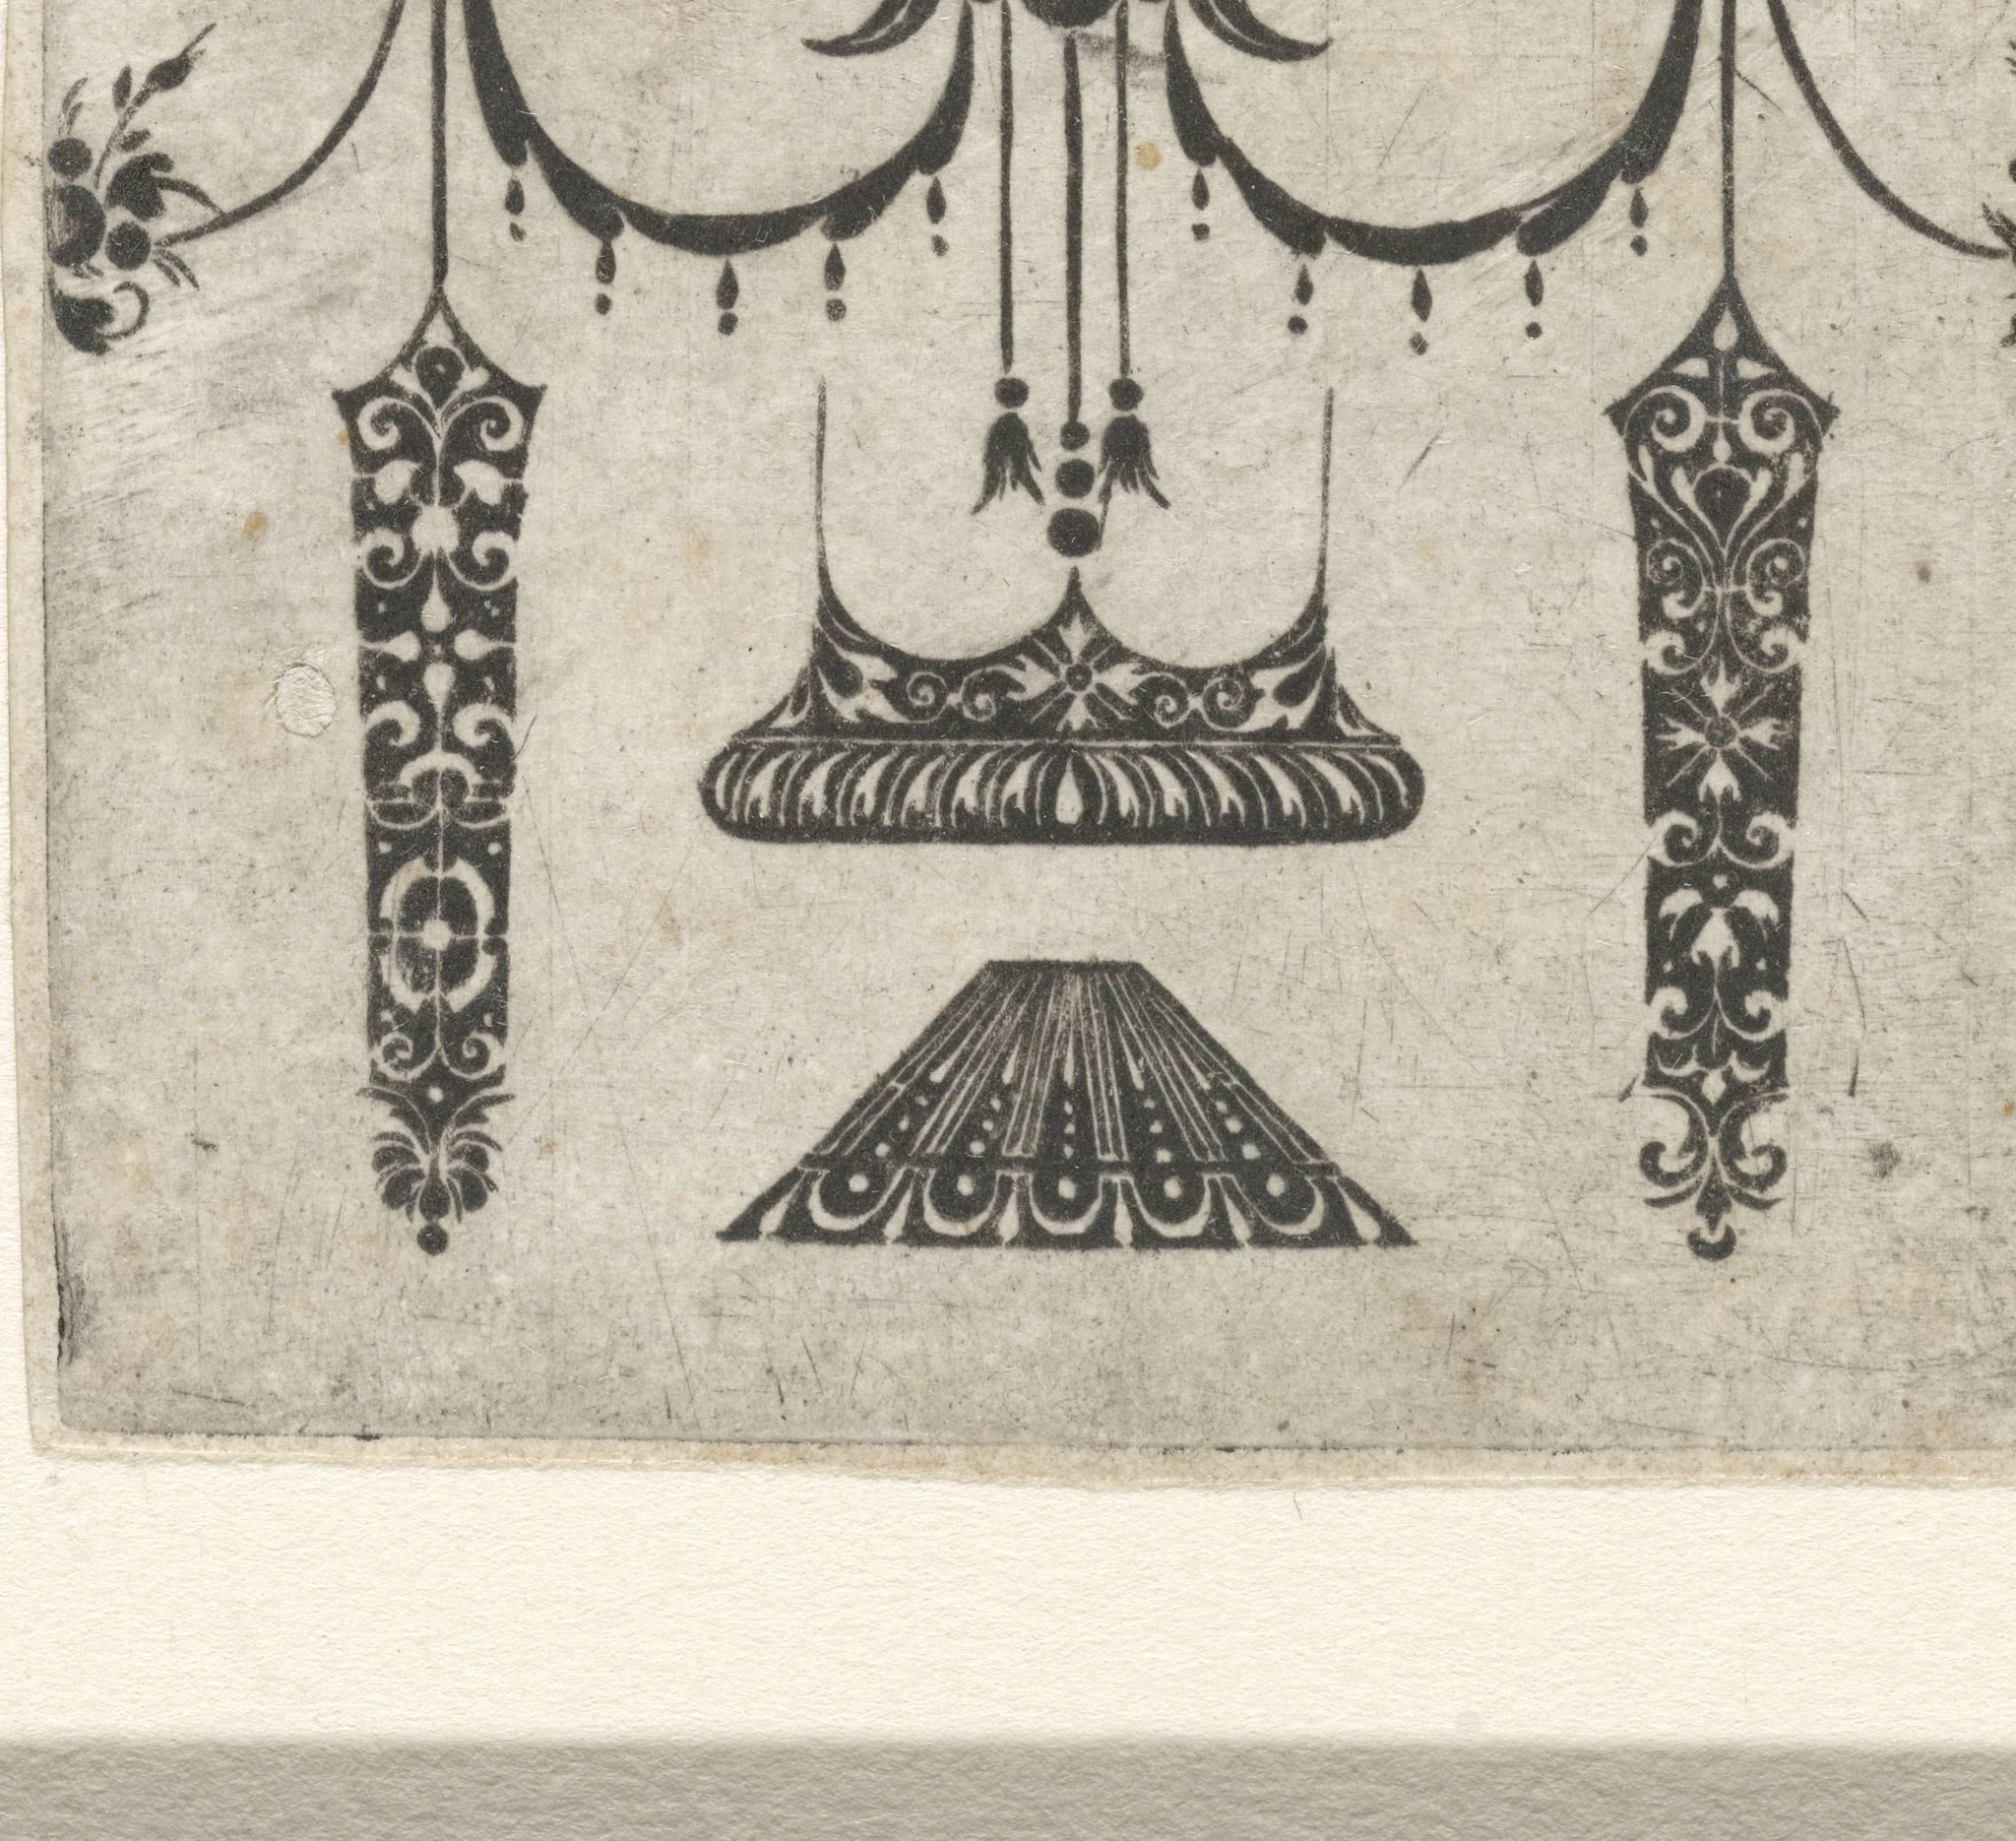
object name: ornament print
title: Ontwerpen voor goudsmeden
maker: Anonymous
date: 1500-1600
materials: paper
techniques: etching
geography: netherlands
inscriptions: inscription: ‘H. de Bull’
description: Aan de guirlande hangt een langwerpig ornament. Middenonder een trapeziumvormig ornament. Een van vier bladen met kleine ornamenten, gedecoreerd met arabesken en geometrische motieven. De decoraties zijn wit op een zwart fond.